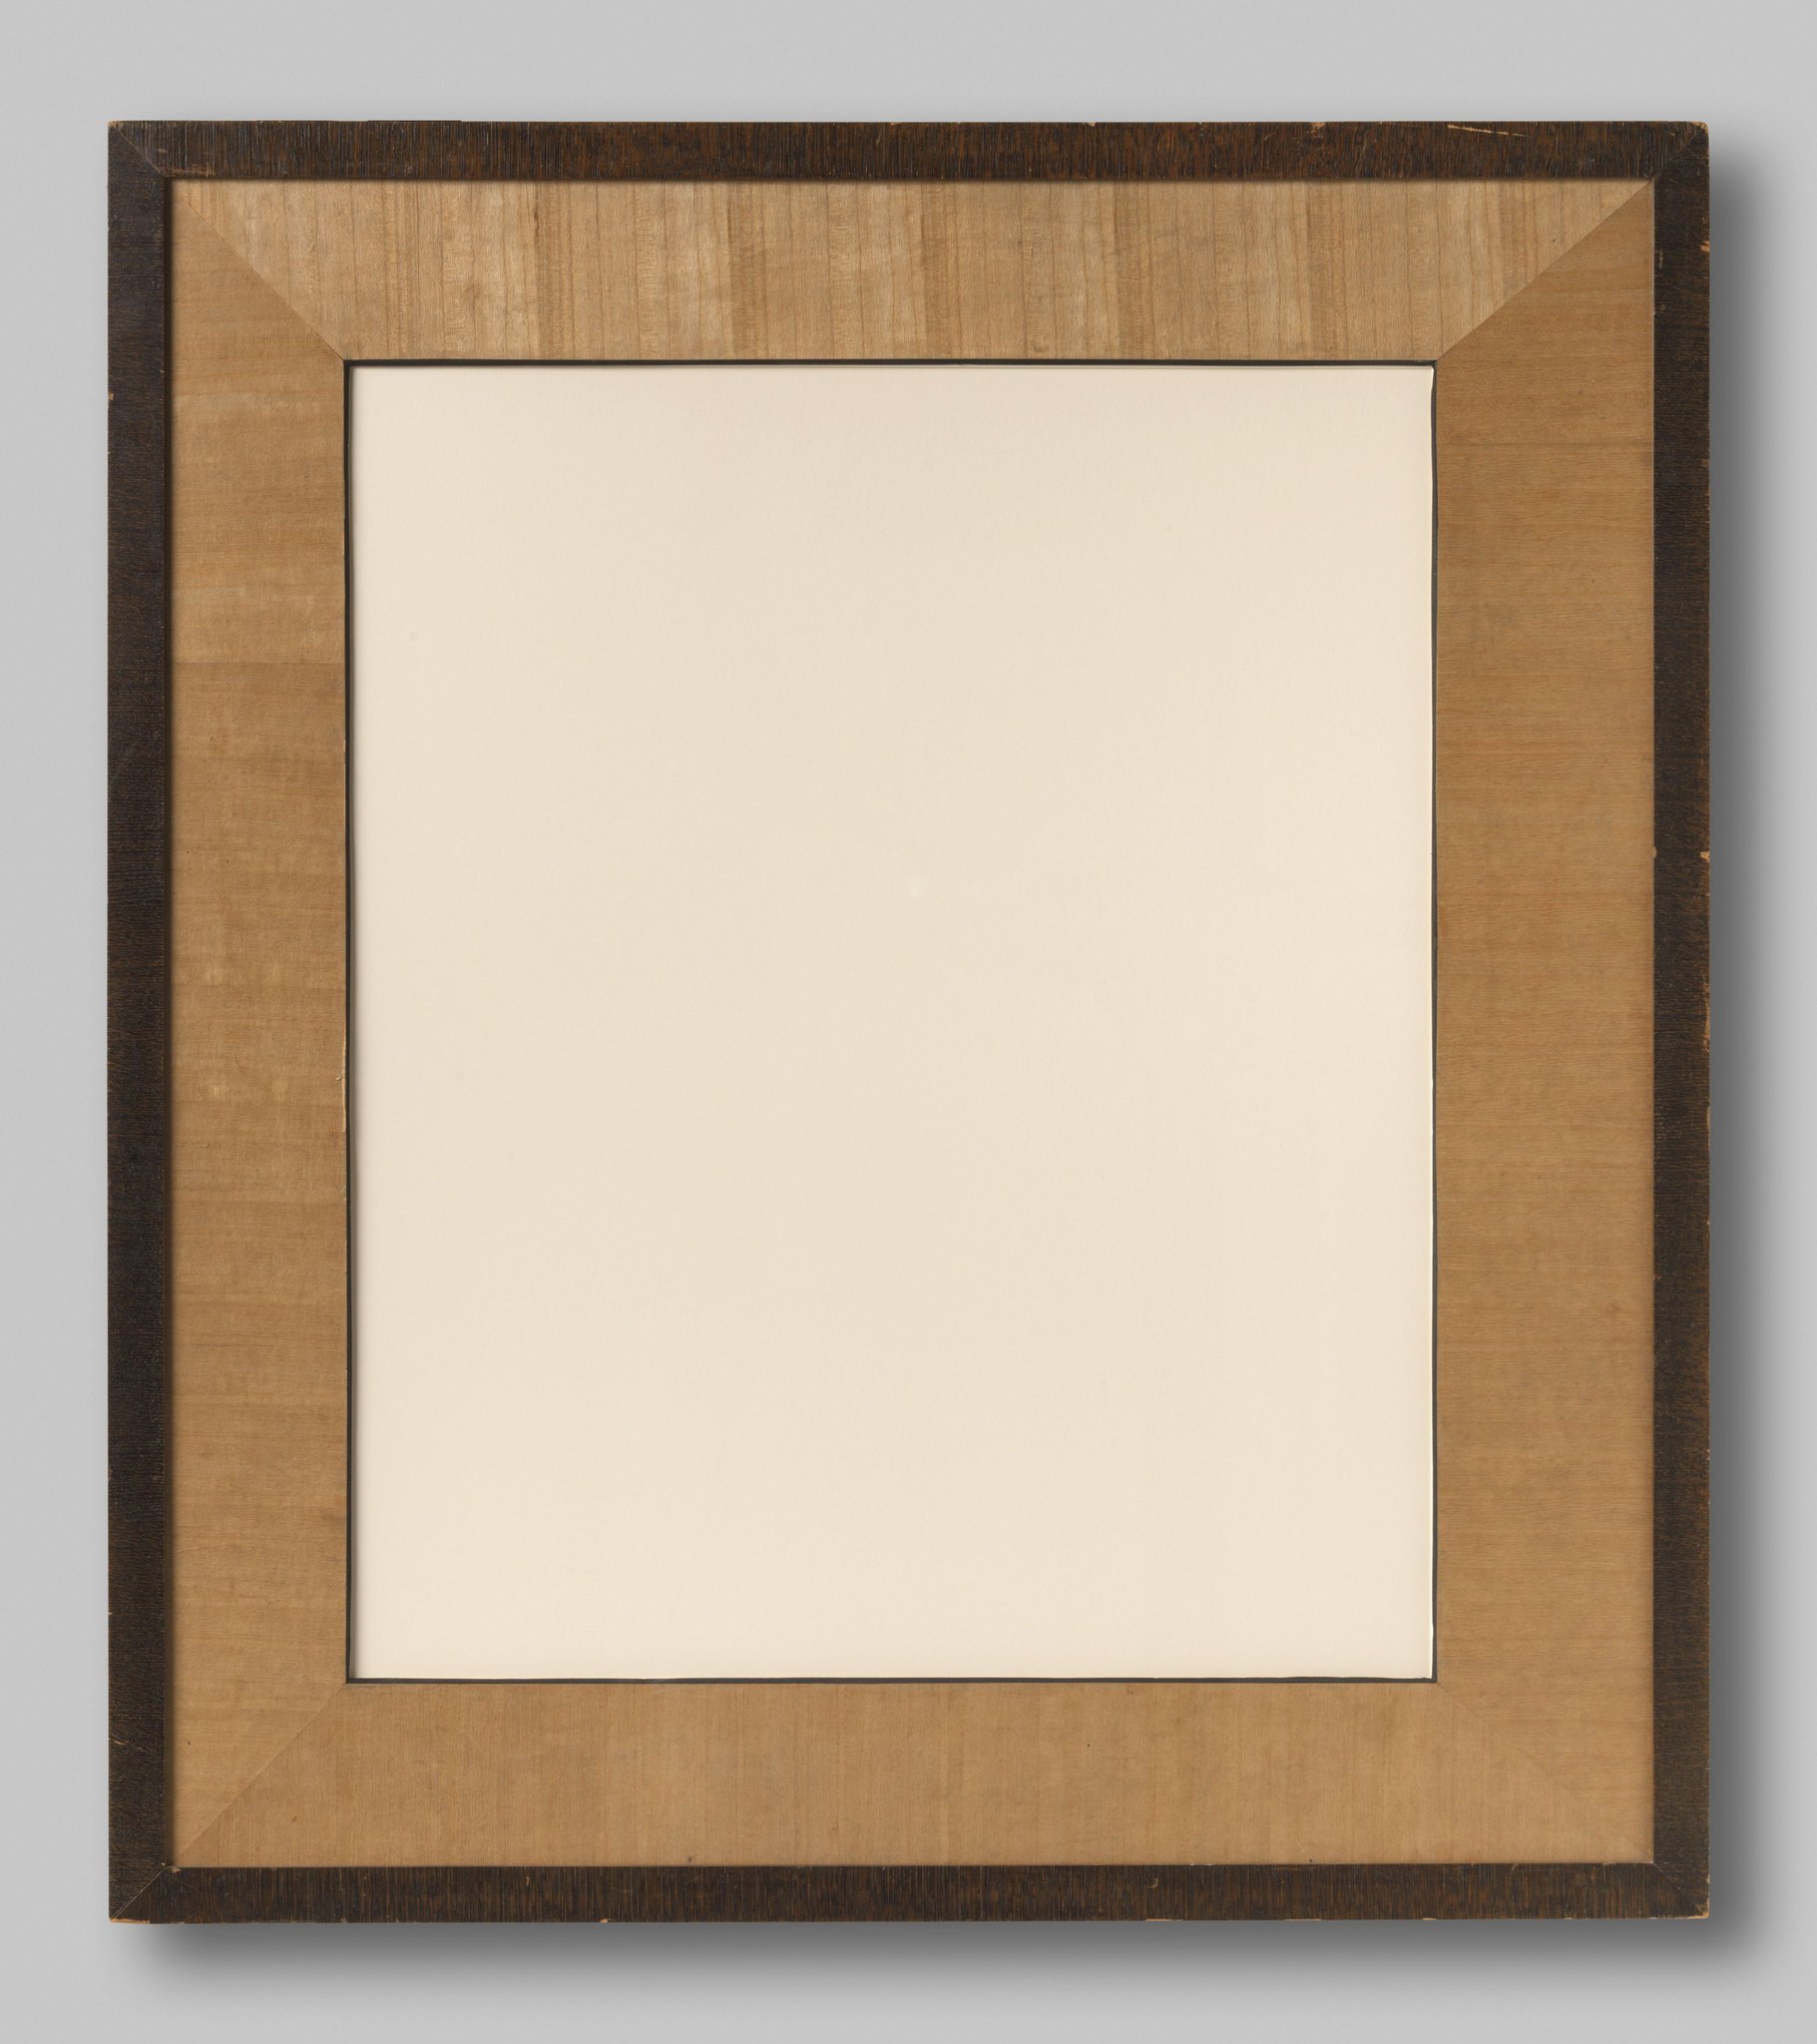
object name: frame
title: Bruine smalle gefineerde houten lijst met gefineerde (blank hout) passe-partout, beglaasd.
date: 1900-1999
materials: wood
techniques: veneer, veneering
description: Houten lijst met glas en houten passe-partout speciaal op maat gemaakt voor RP-P-2003-226.